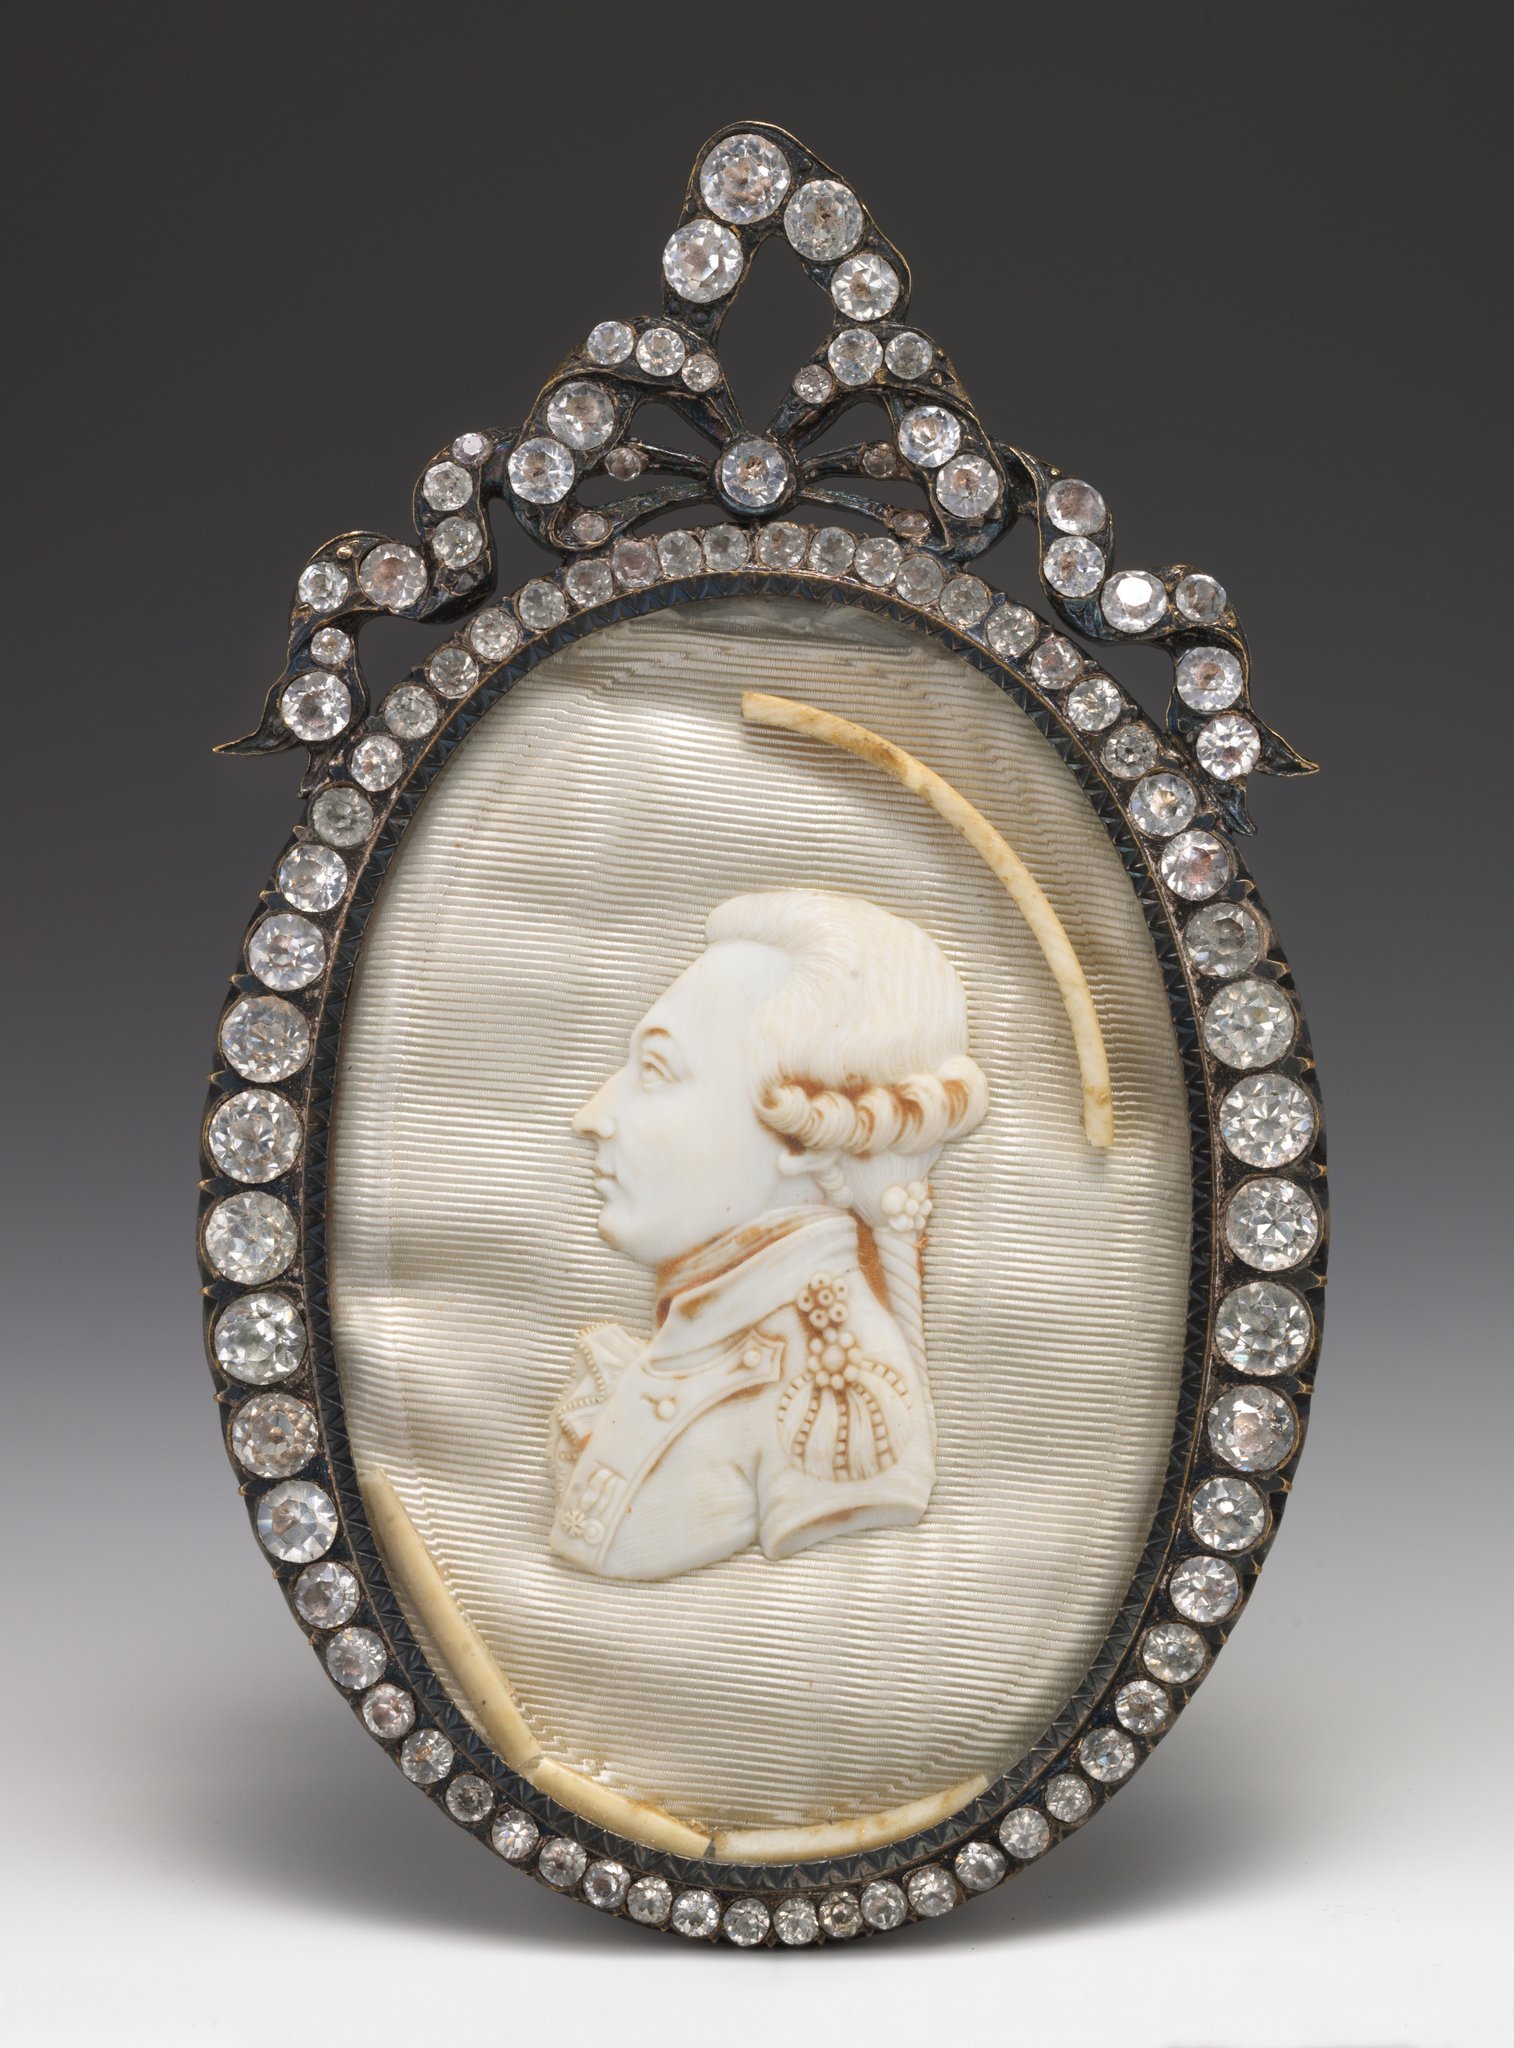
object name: relief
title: Marie-Joseph Paul Yves Roch Gilbert du Motier, Marquis de Lafayette (1757–1834)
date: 1701-1800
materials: ivory, silk, silver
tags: men,profiles,marquis de lafayette